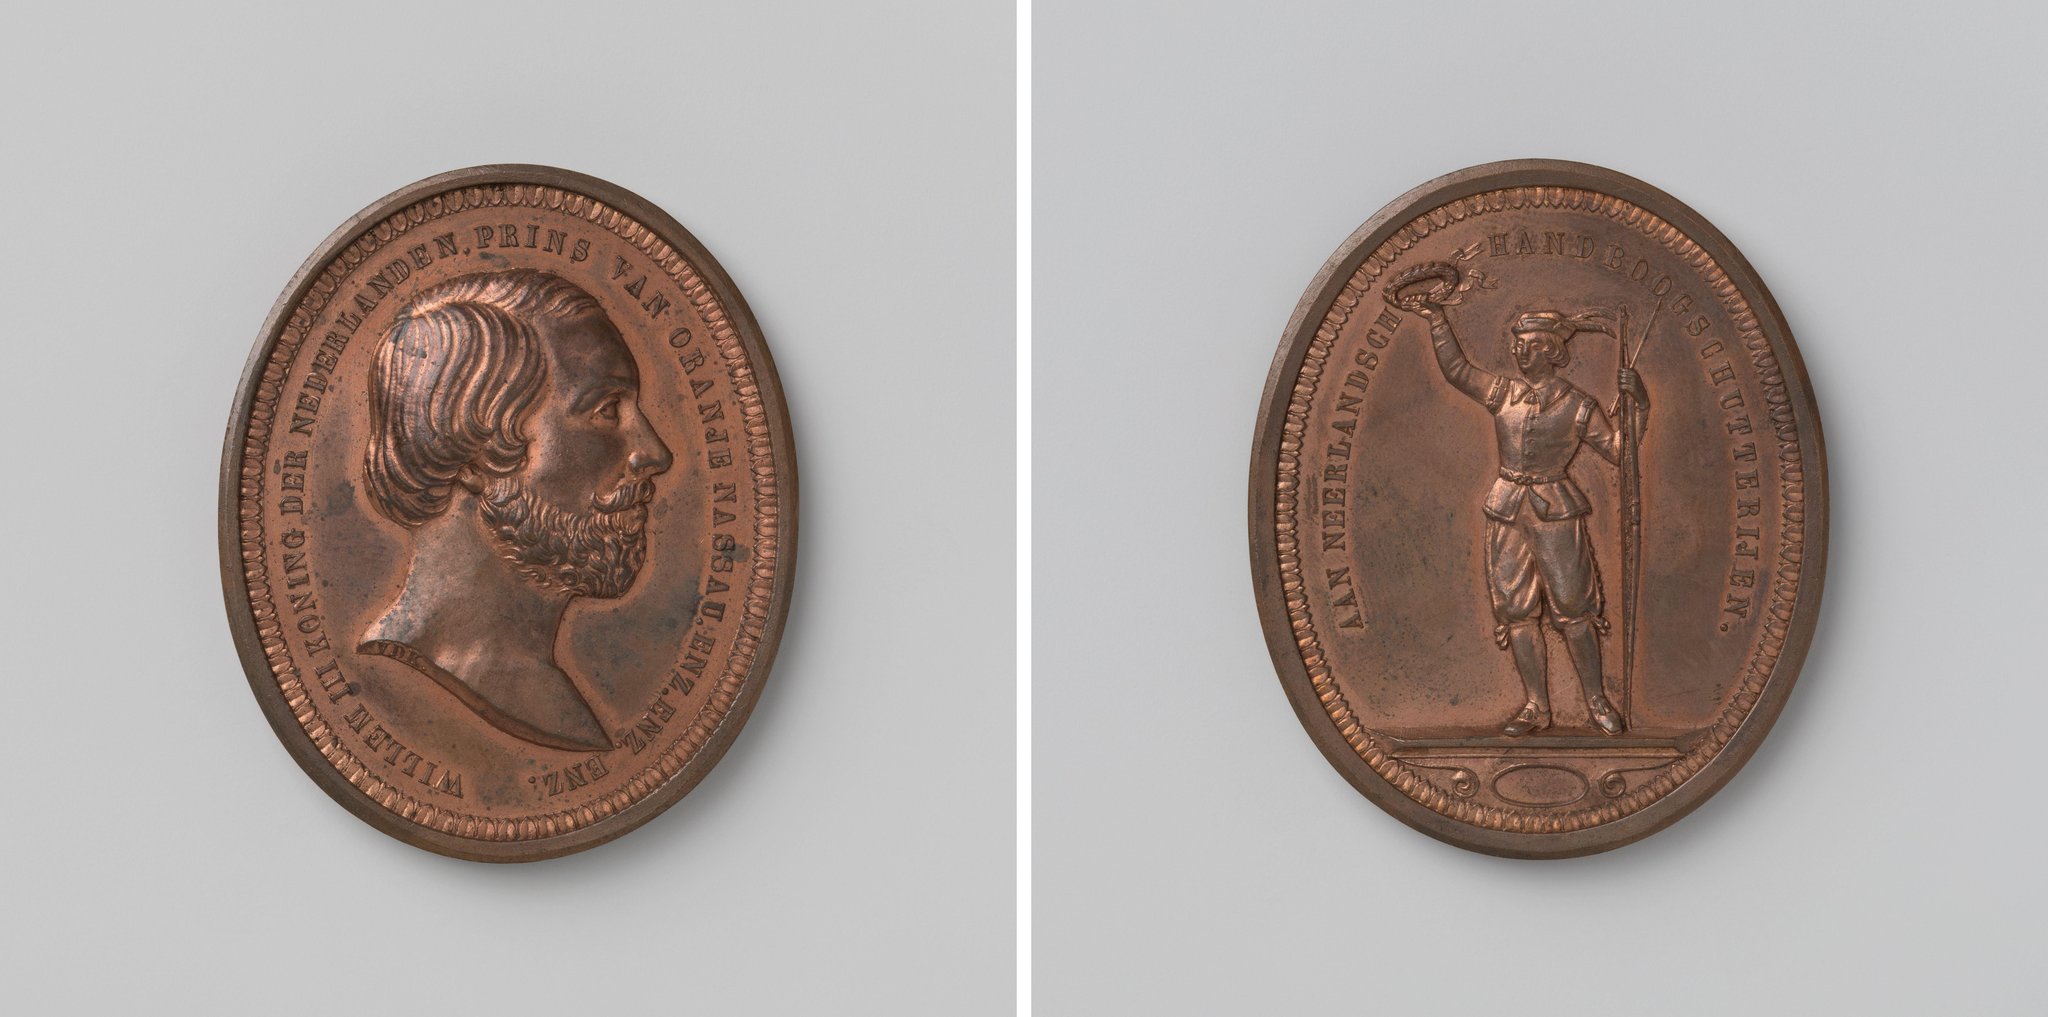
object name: marksman medal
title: Neerlands Handboog Schutterijen, penning ter ere van Willem III, koning der Nederlanden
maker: david van der kellen (1804-1879)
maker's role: die cutter, draughtsman, print maker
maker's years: 1804-1879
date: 1851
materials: bronze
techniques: striking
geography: utrecht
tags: brussels, willem iii (koning der nederlanden), netherlands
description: Bronzen ovale penning. Voorzijde: borststuk man binnen omschrift. Keerzijde: schutter met gepluimde muts houdt boog en pijlen in linker- en lauwerkrans in geheven rechterhand binnen omschrift; afsnede: leeg compartiment